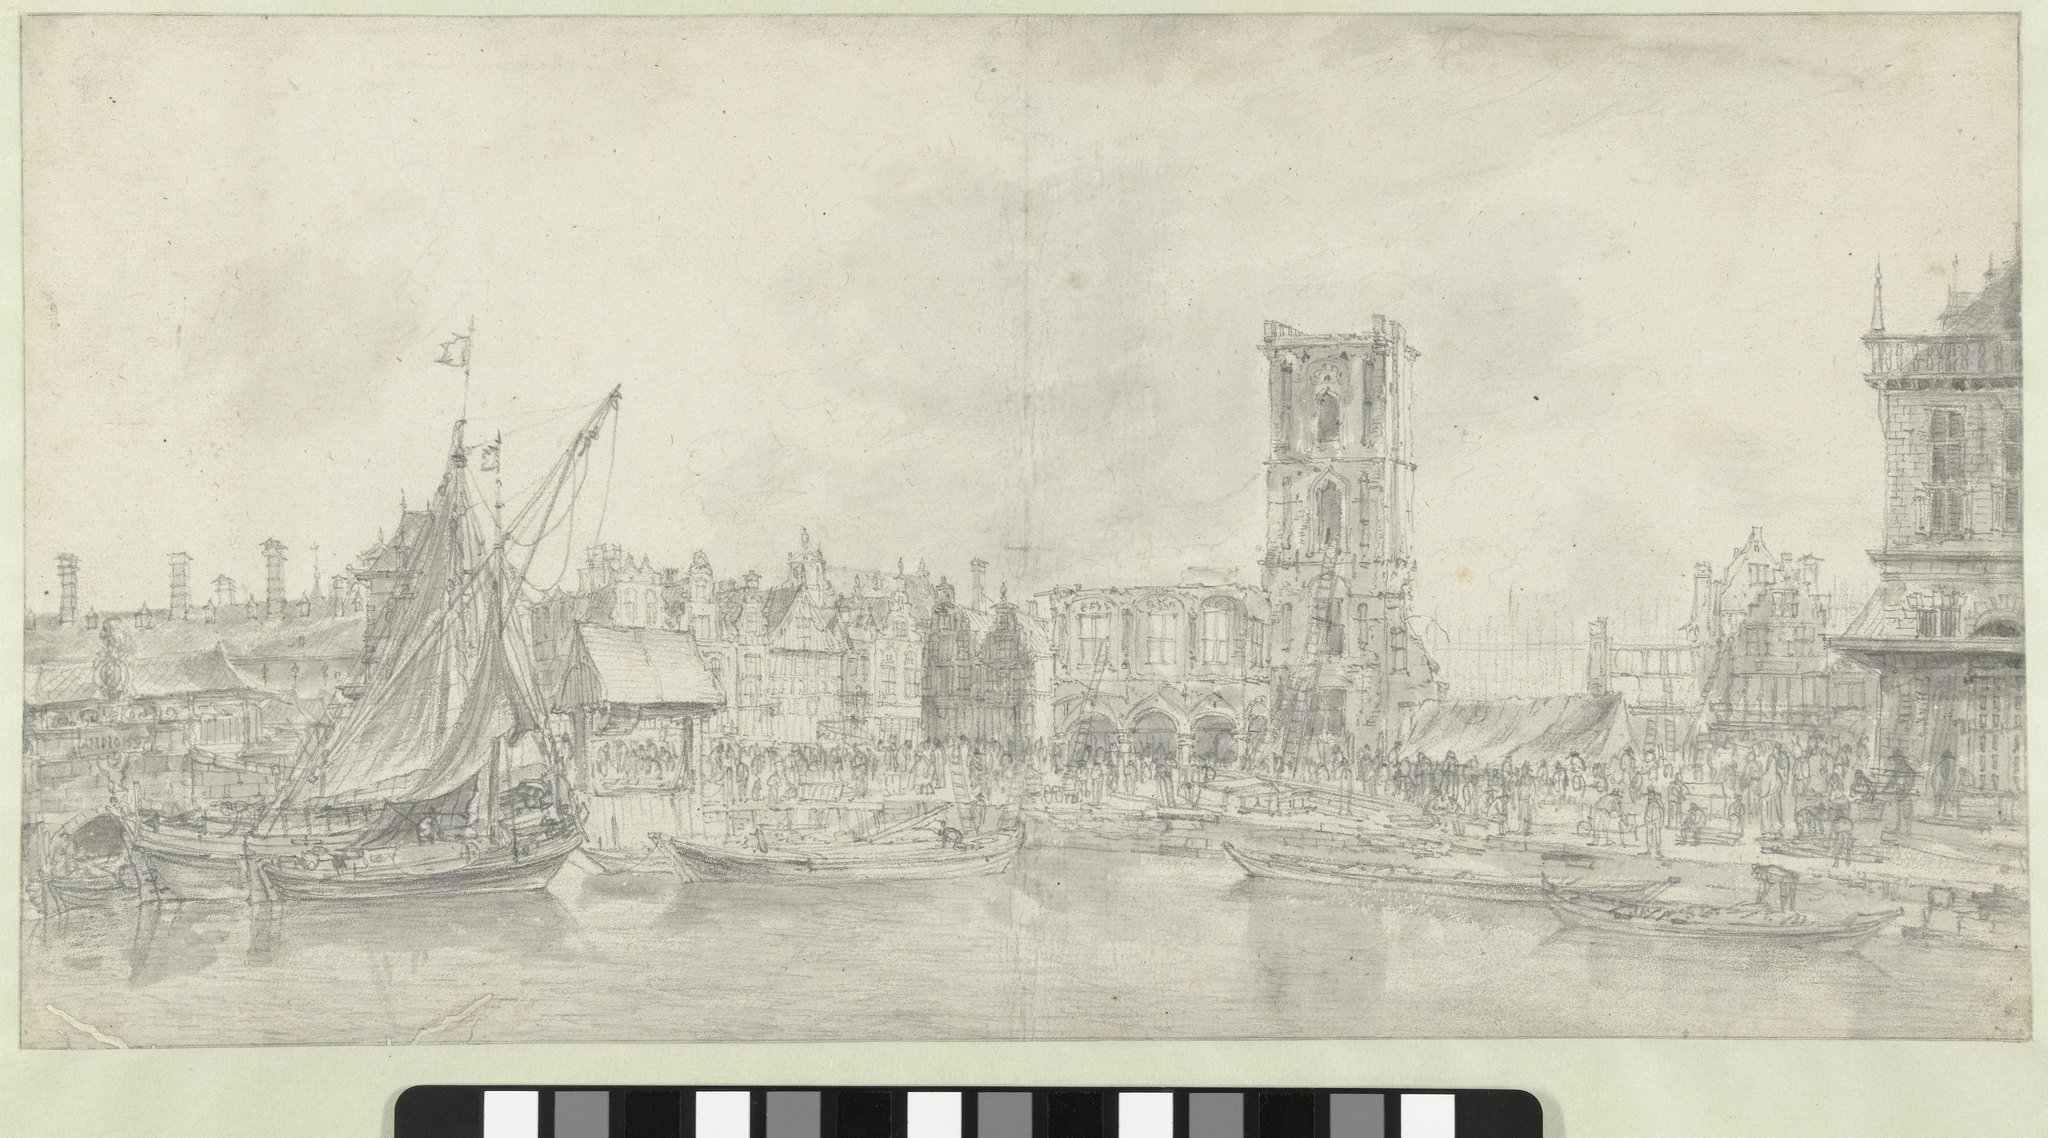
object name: historieplaat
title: Uitgebrande ruïne van het oude Amsterdamse stadhuis, 1652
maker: jan abrahamsz. beerstraten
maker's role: draughtsman, painter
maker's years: 1622-1666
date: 1652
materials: chalk, paper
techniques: brush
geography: northern netherlands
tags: ruin of a building ~ architecture, townhall, square, place, circus, etc. (+ city(-scape) with figures, staffage)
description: De ruïne van het Oude Stadhuis van Amsterdam na de brand van 7 juli 1652. Rechts de Waag, links de Vismarkt, het water van het Damrak op de voorgrond, het plein vol mensen.